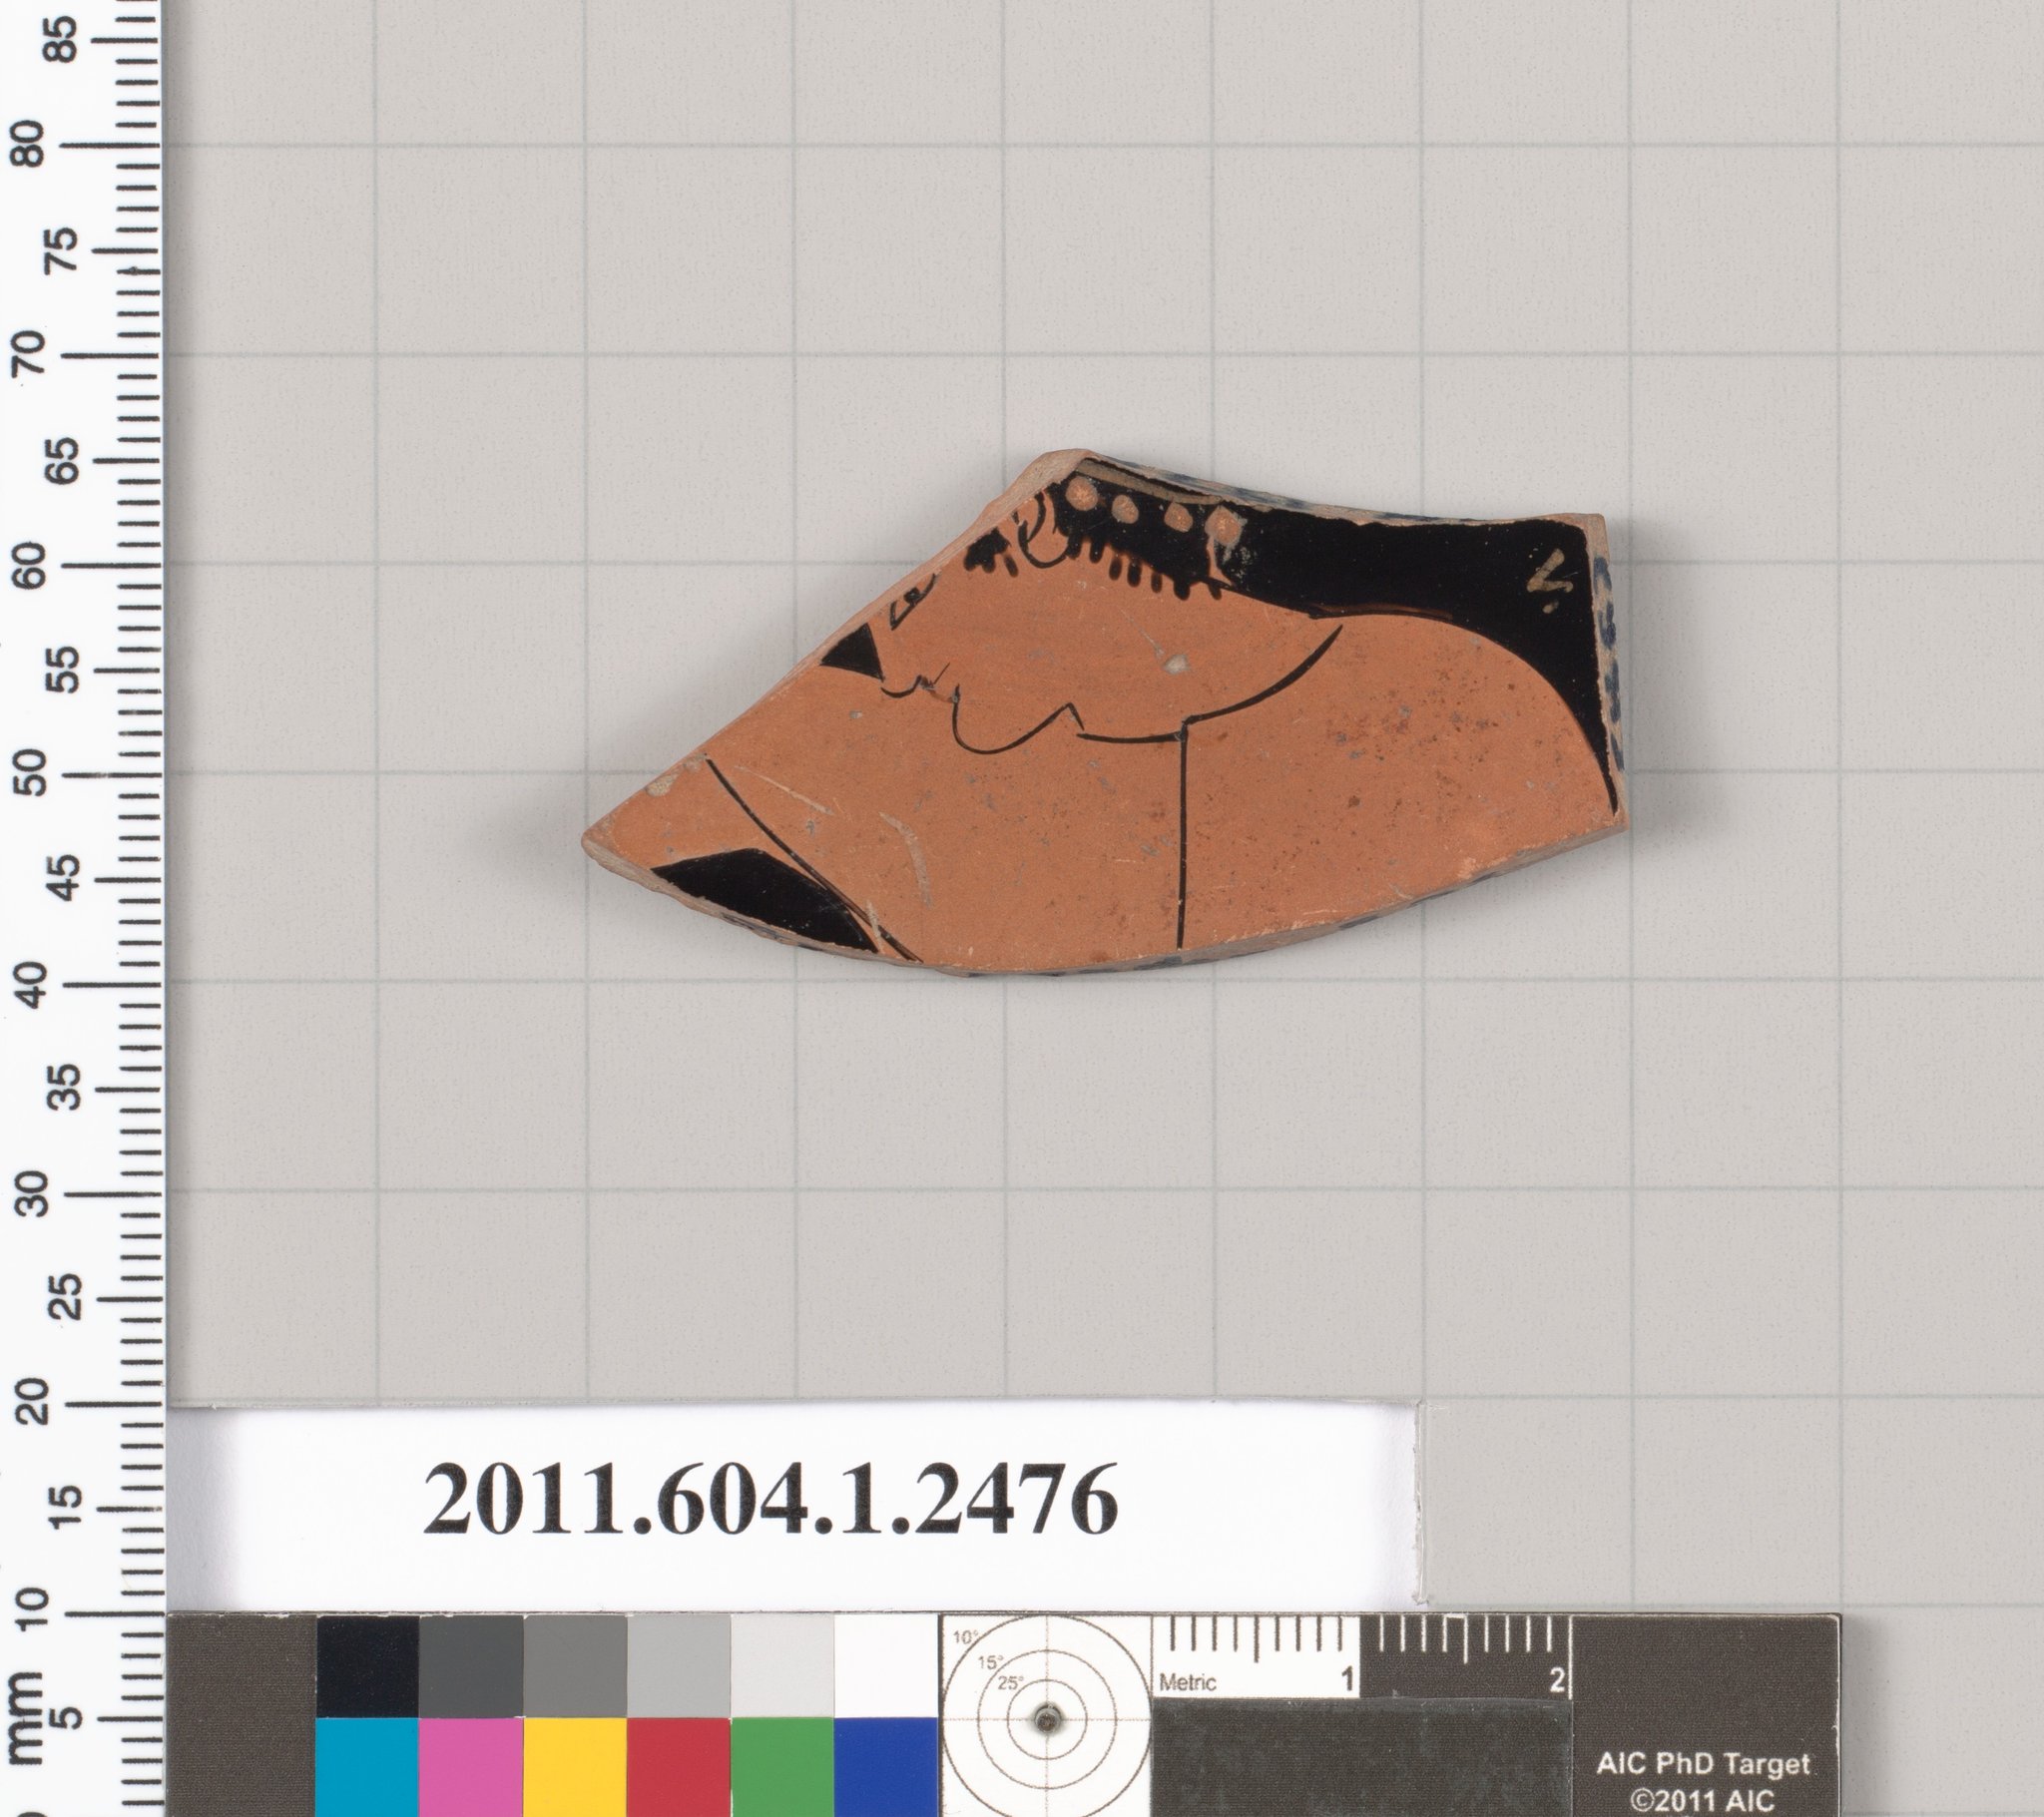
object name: kylix fragment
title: Terracotta fragment of a kylix (drinking cup)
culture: greek, attic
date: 520-500 BCE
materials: terracotta